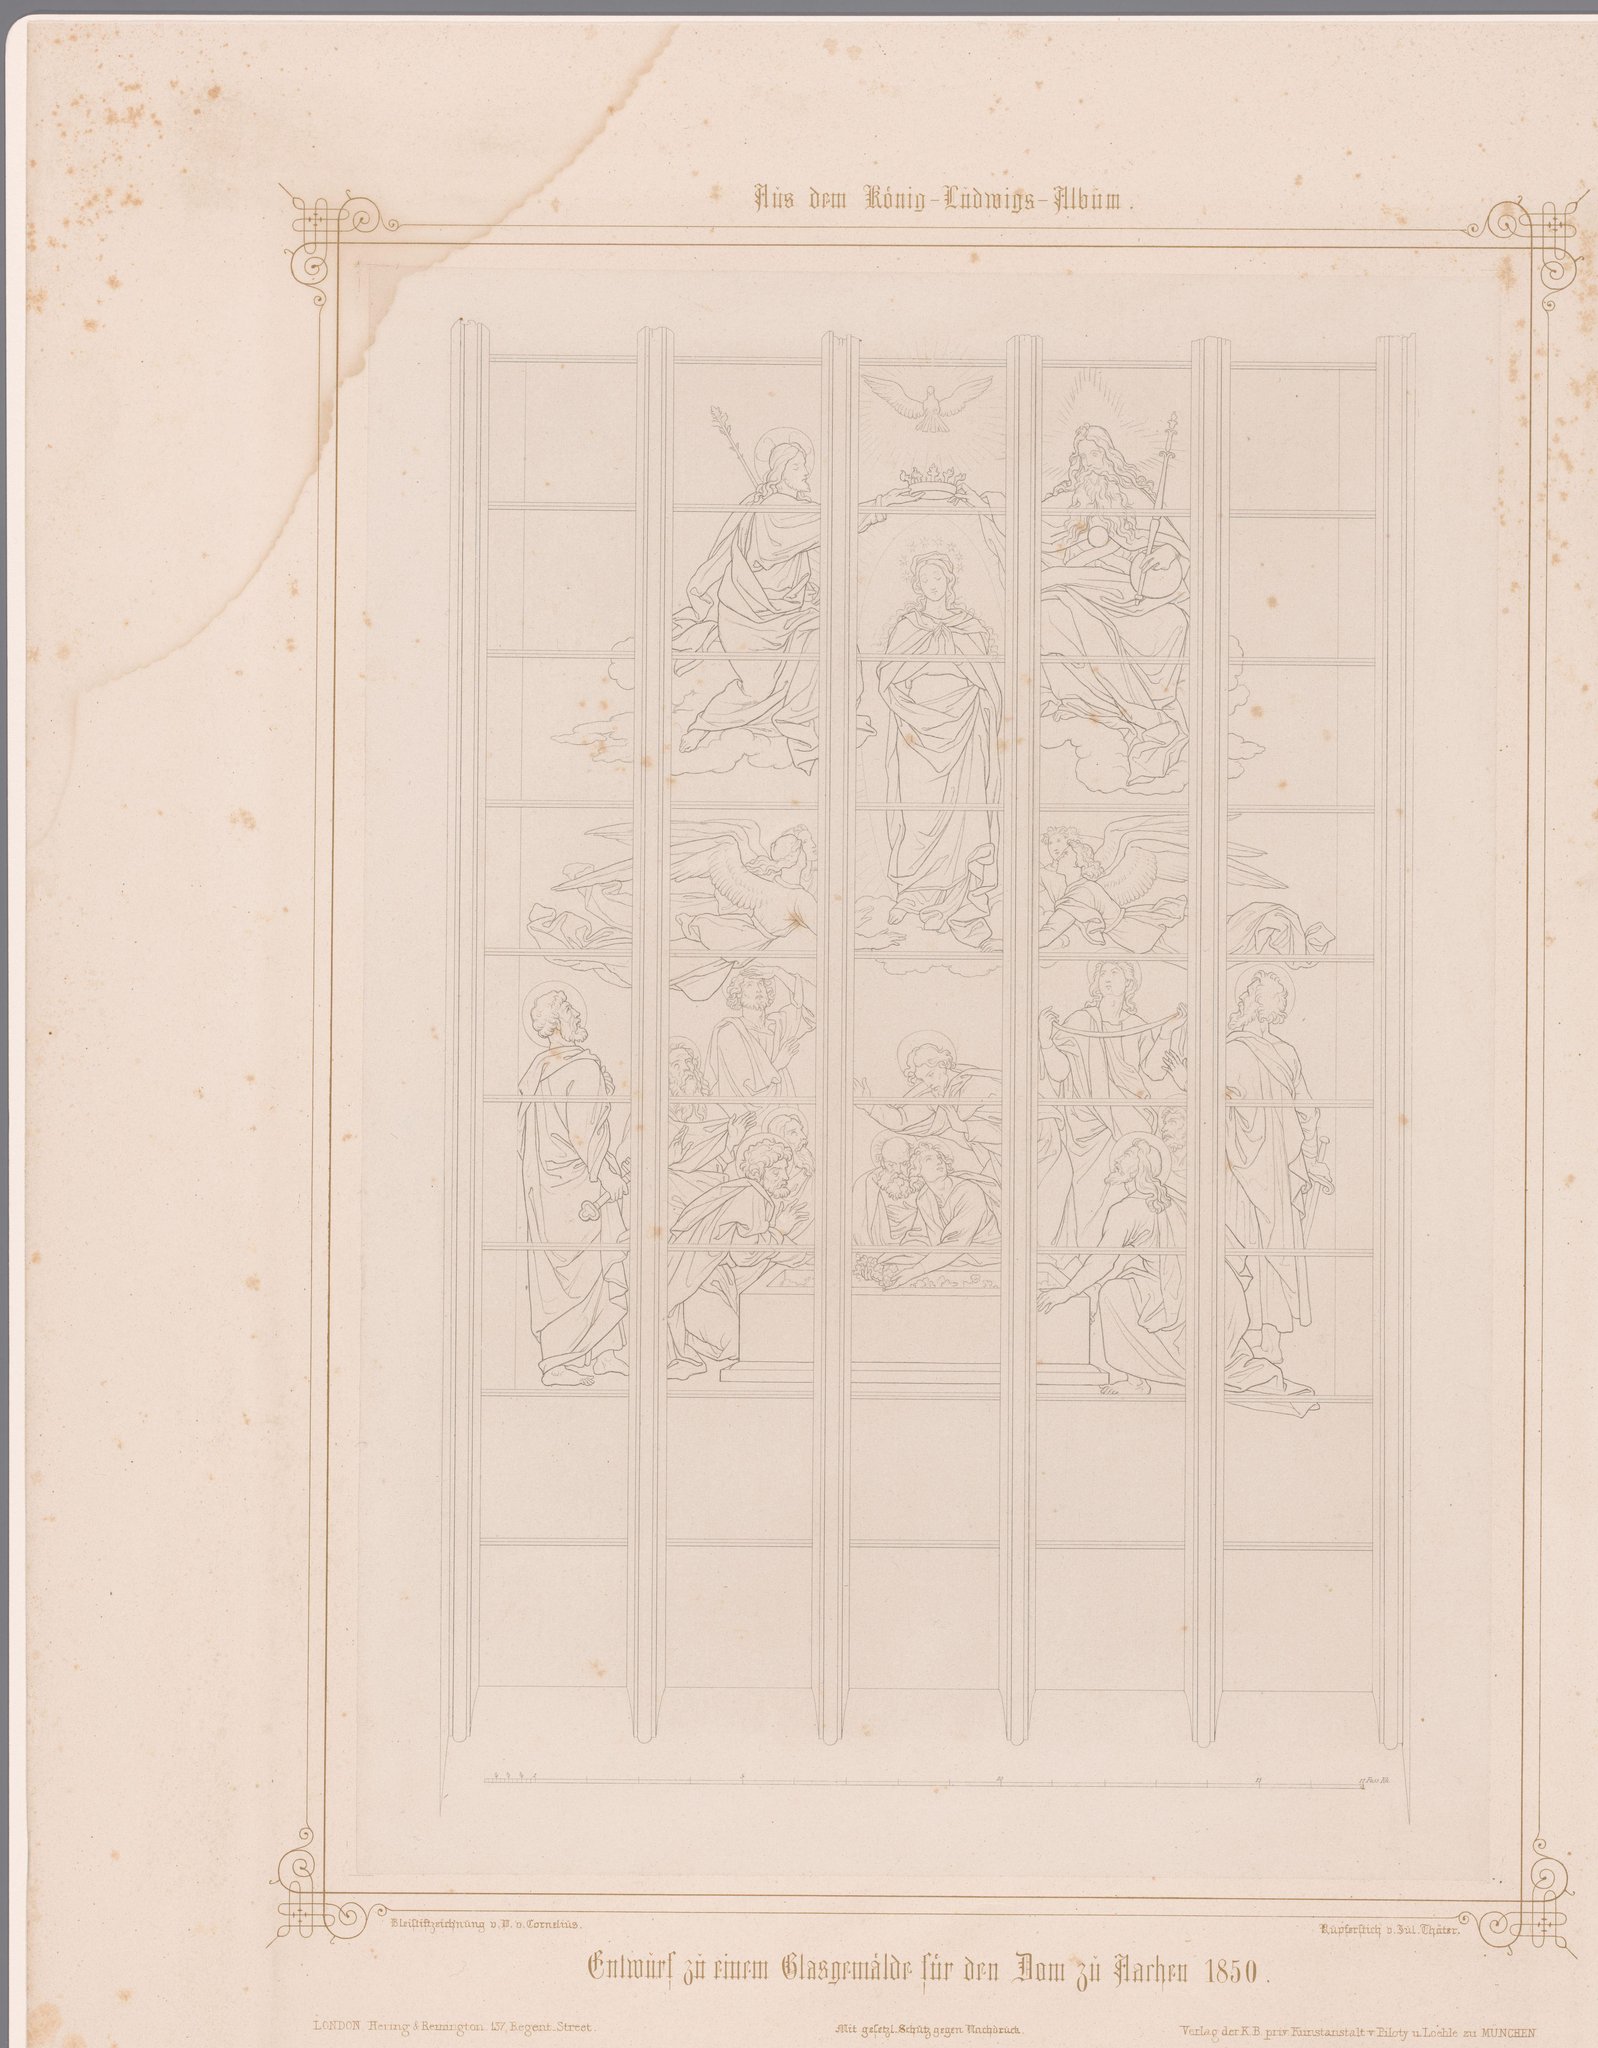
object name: print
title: König-Ludwigs Album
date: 1850-1859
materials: paper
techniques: lithograph, engraving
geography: munich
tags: coronation of mary in heaven (usually the holy trinity present)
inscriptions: collector's mark: Lugt 2228, check stamp: ‘Piloty & Löhle/ KGL.Bayr.Priv.Kunstanstalt/ München’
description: Prent afkomstig uit de serie 'Album Seiner Majestät des Königs Ludwig I. von Bayern', verschenen in verschillende afleveringen. De prenten gaan terug op het album dat Lodewijk I van Beieren op 9 oktober 1850 kreeg overhandigd van verschillende kunstenaars.